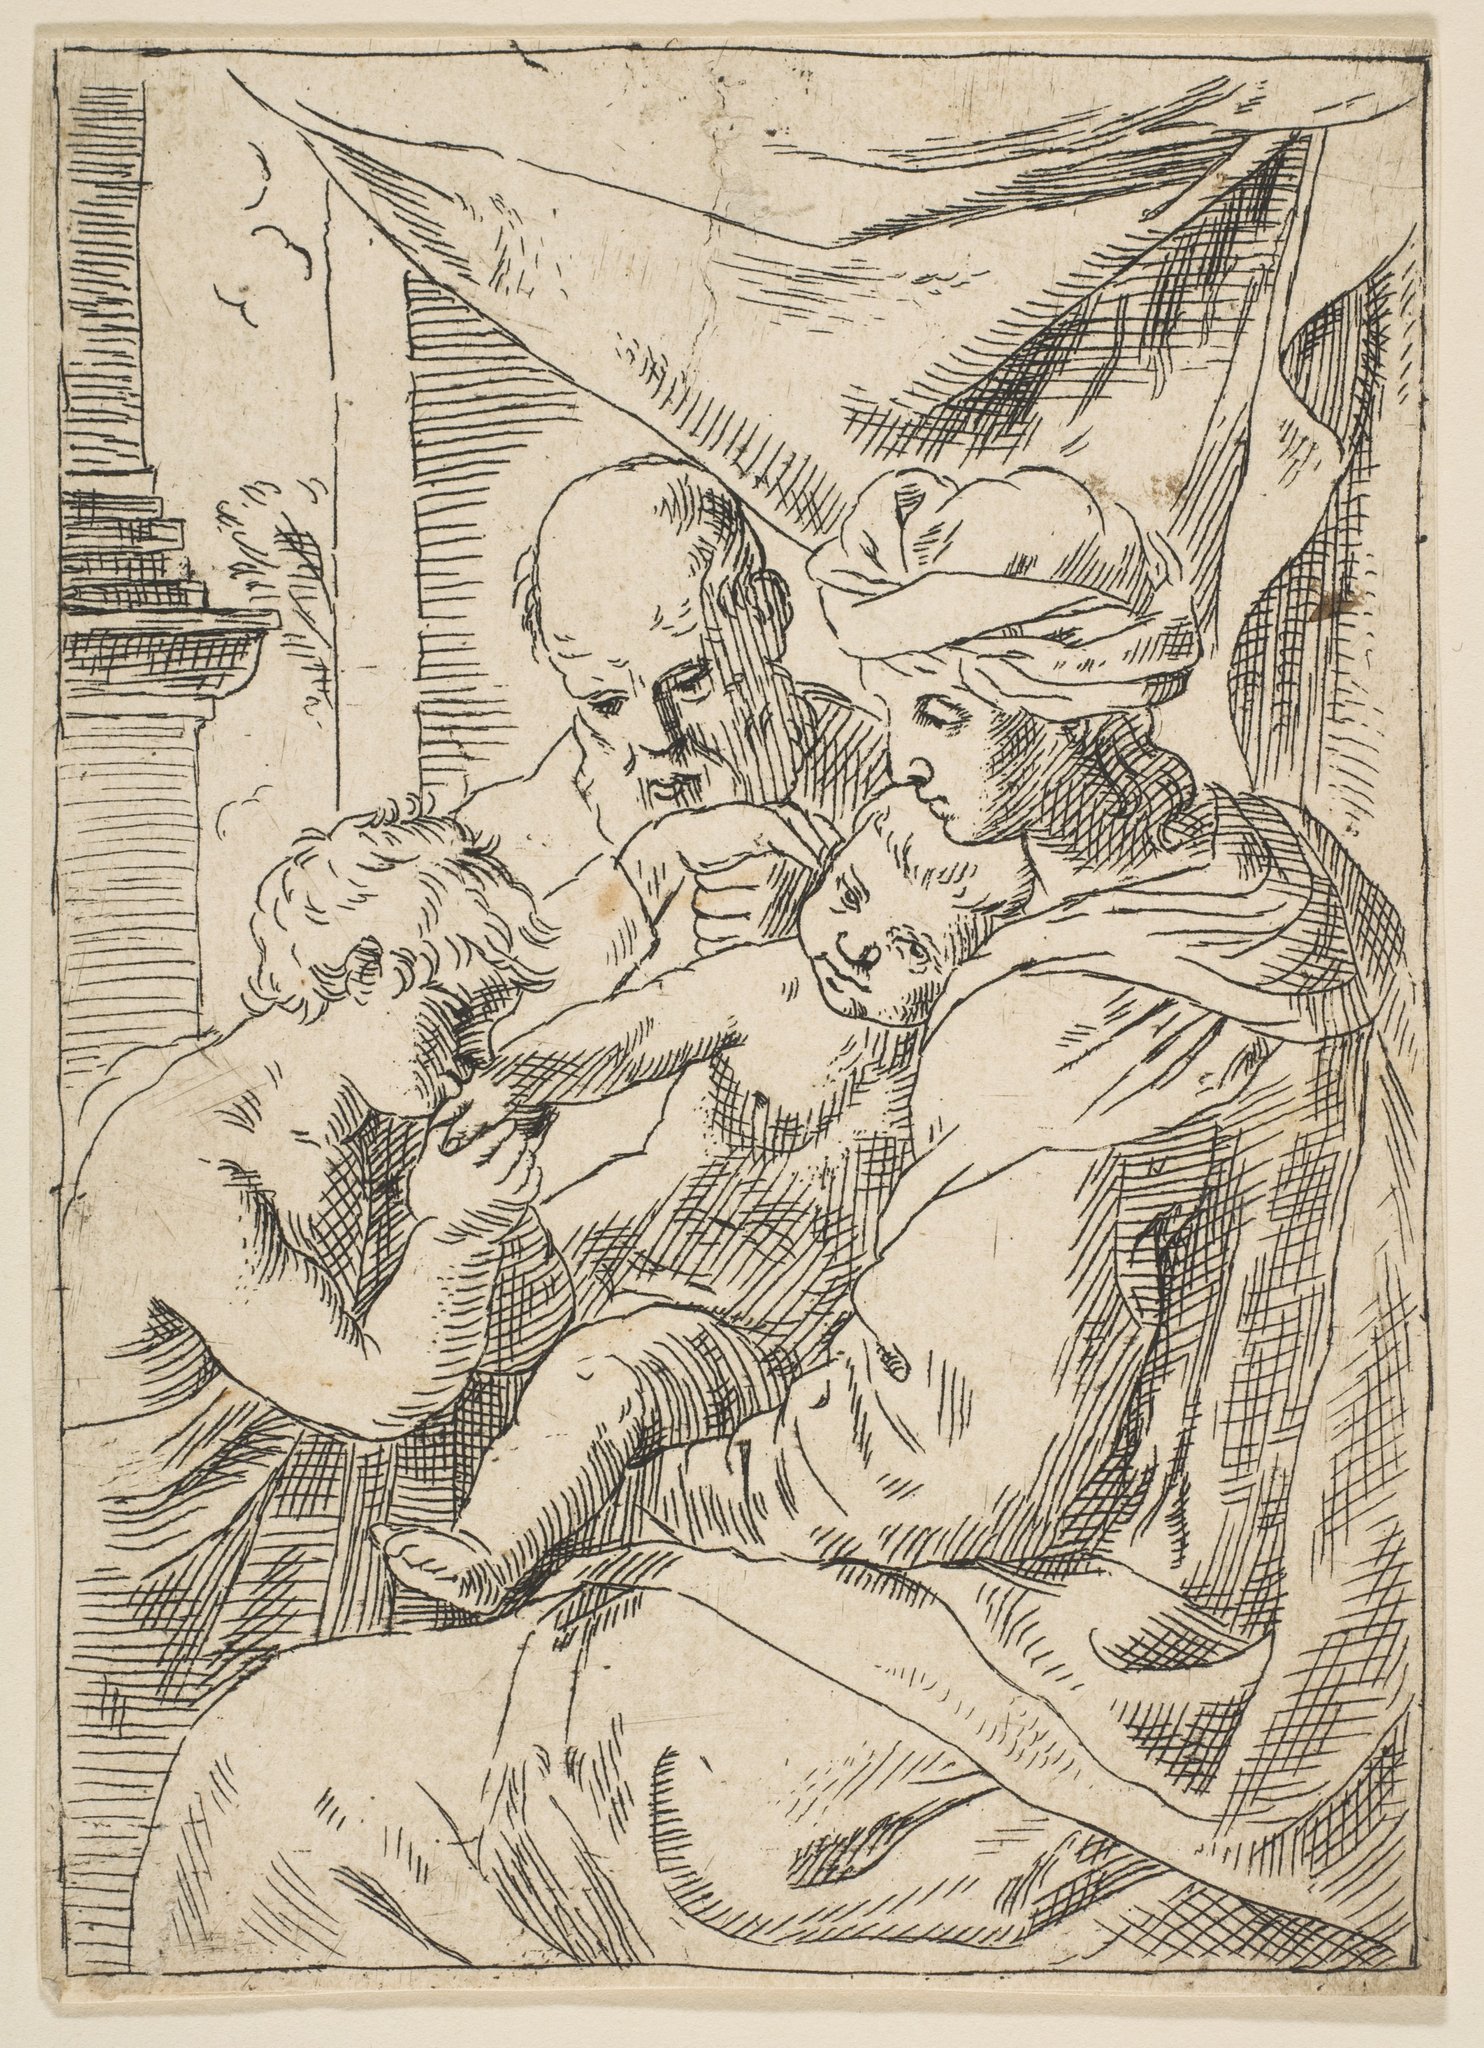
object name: print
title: Holy Family with Saint John the Baptist kissing the infant Christ's hand, copy in reverse after Cantarini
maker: simone cantarini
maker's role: artist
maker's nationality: italian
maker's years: 1612-1648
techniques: etching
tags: christ,holy family,saint john the baptist